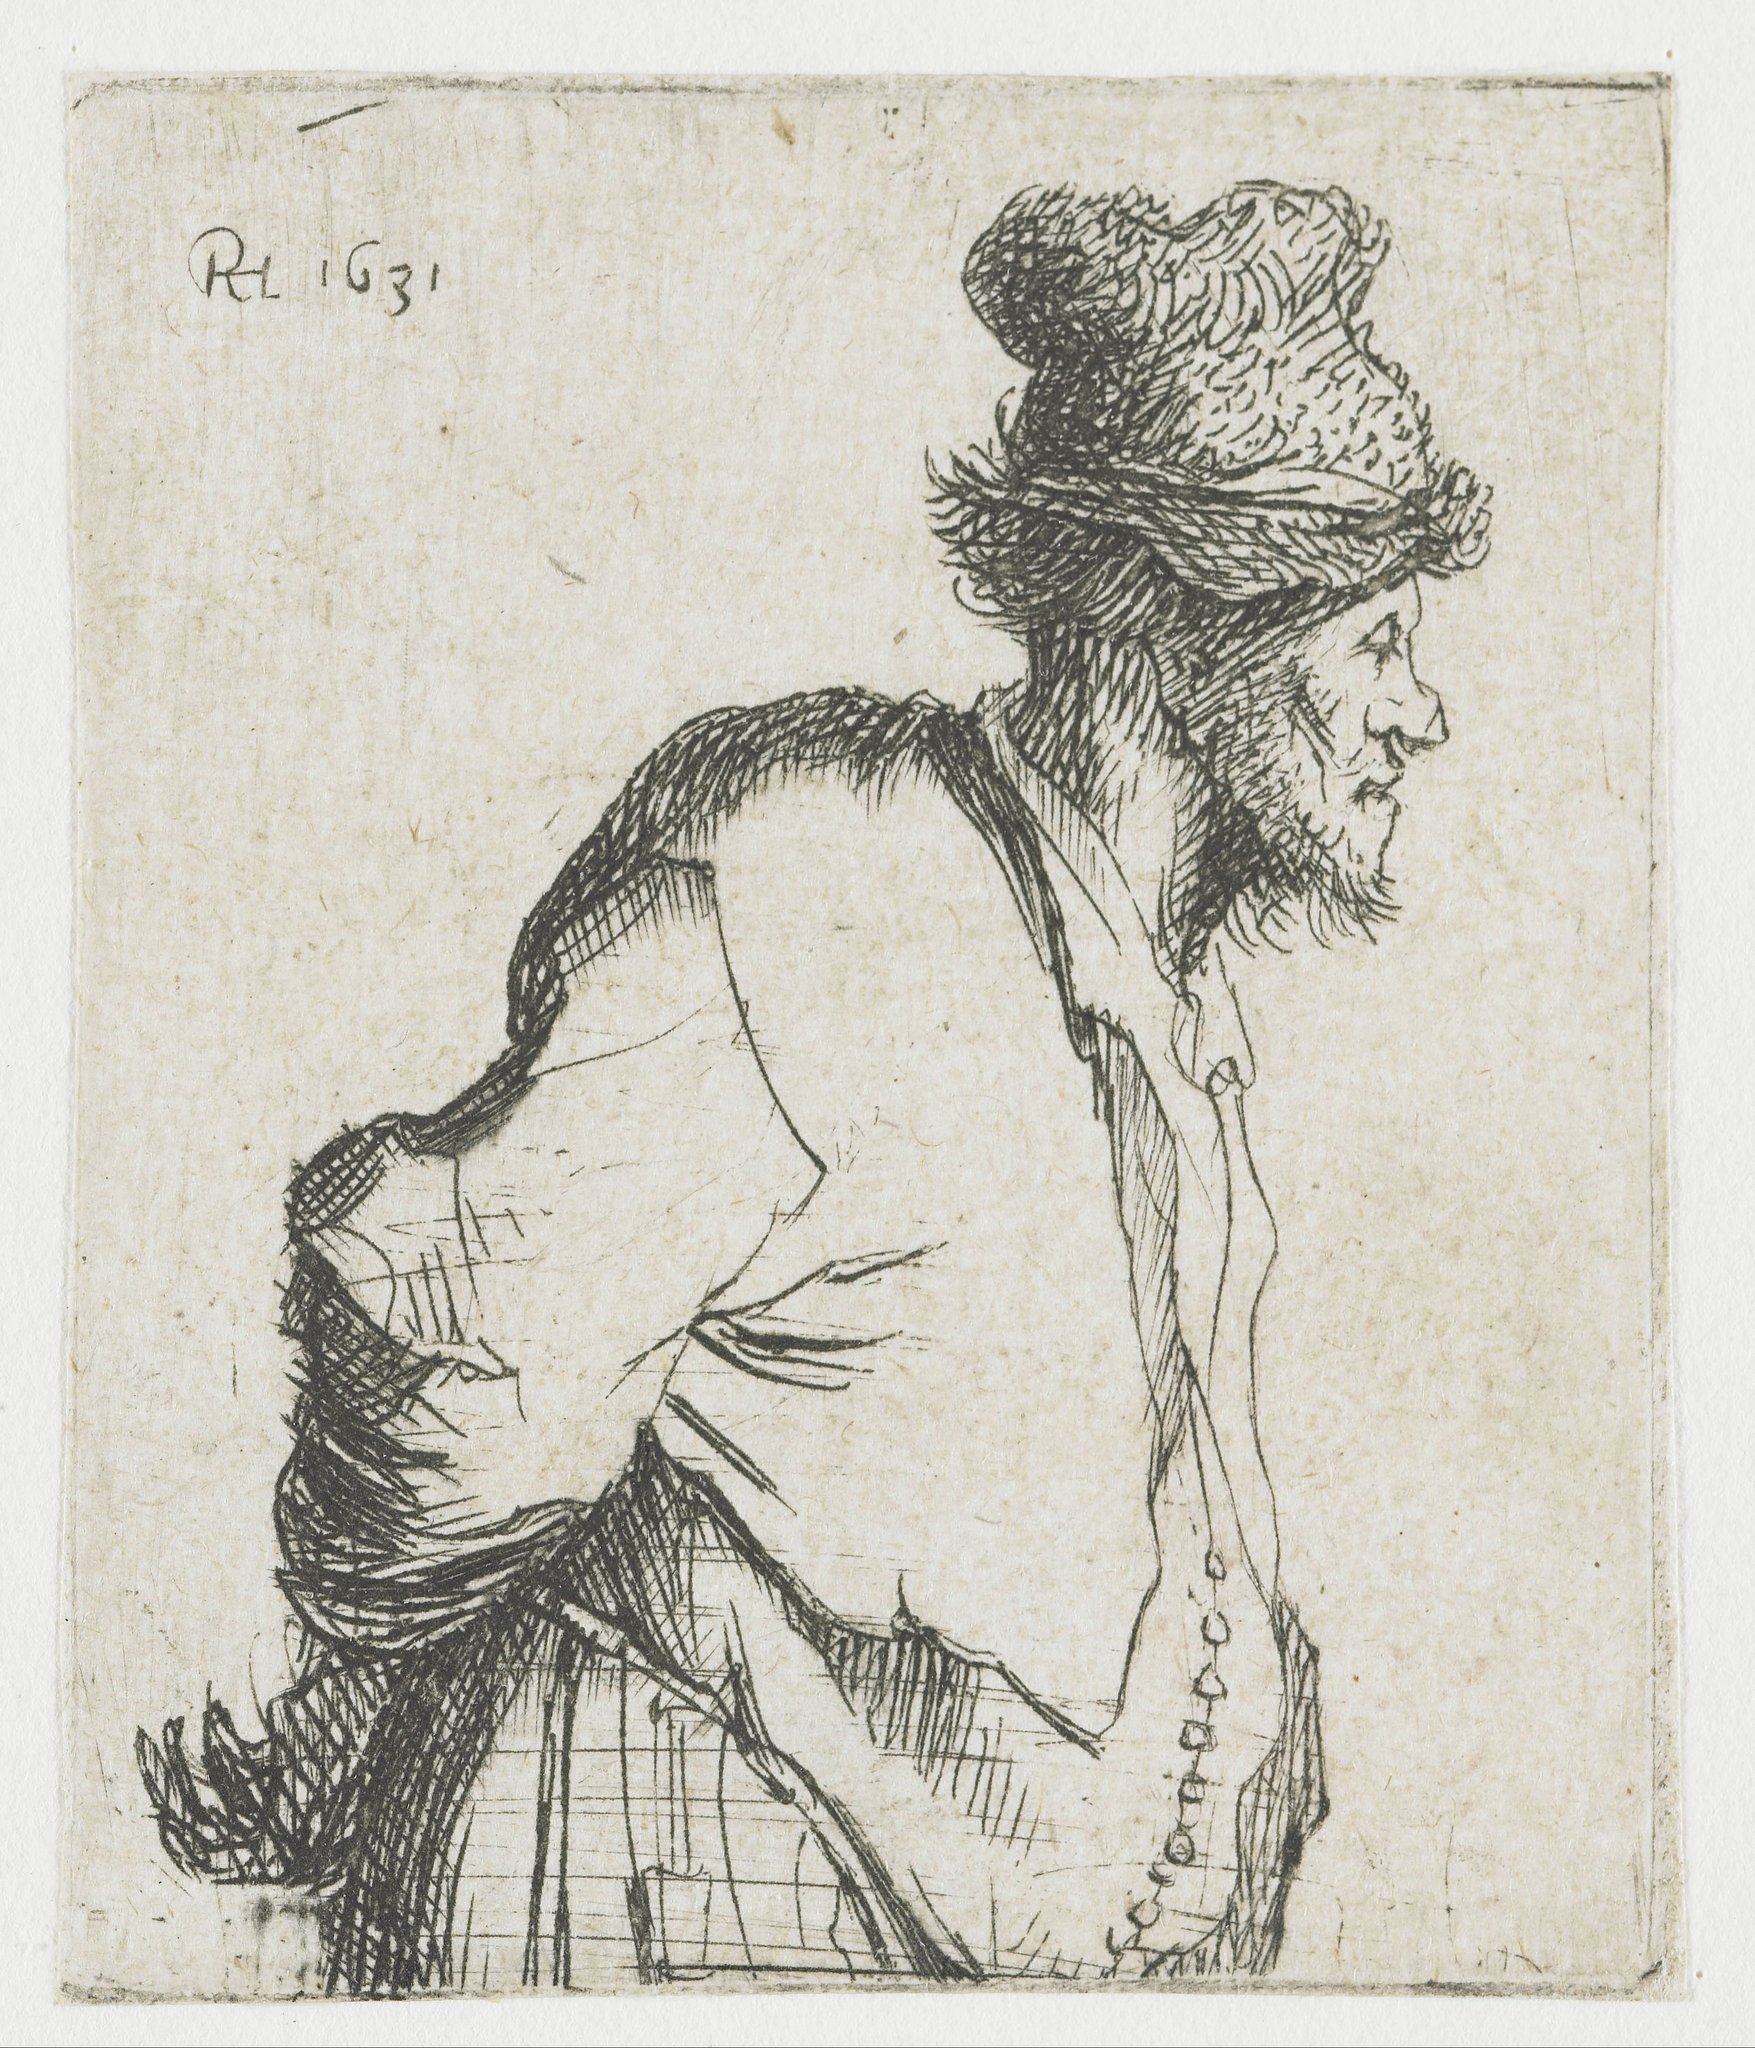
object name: print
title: Peasant with his hands behind his back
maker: rembrandt van rijn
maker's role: draughtsman, painter, print maker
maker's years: 1606-1669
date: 1629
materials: paper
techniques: etching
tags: adult man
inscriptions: monogram and date: ‘RHL 1631’, collector's mark: Lugt 240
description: De prent is gedateerd 1631, maar mogelijk niet door Rembrandt.